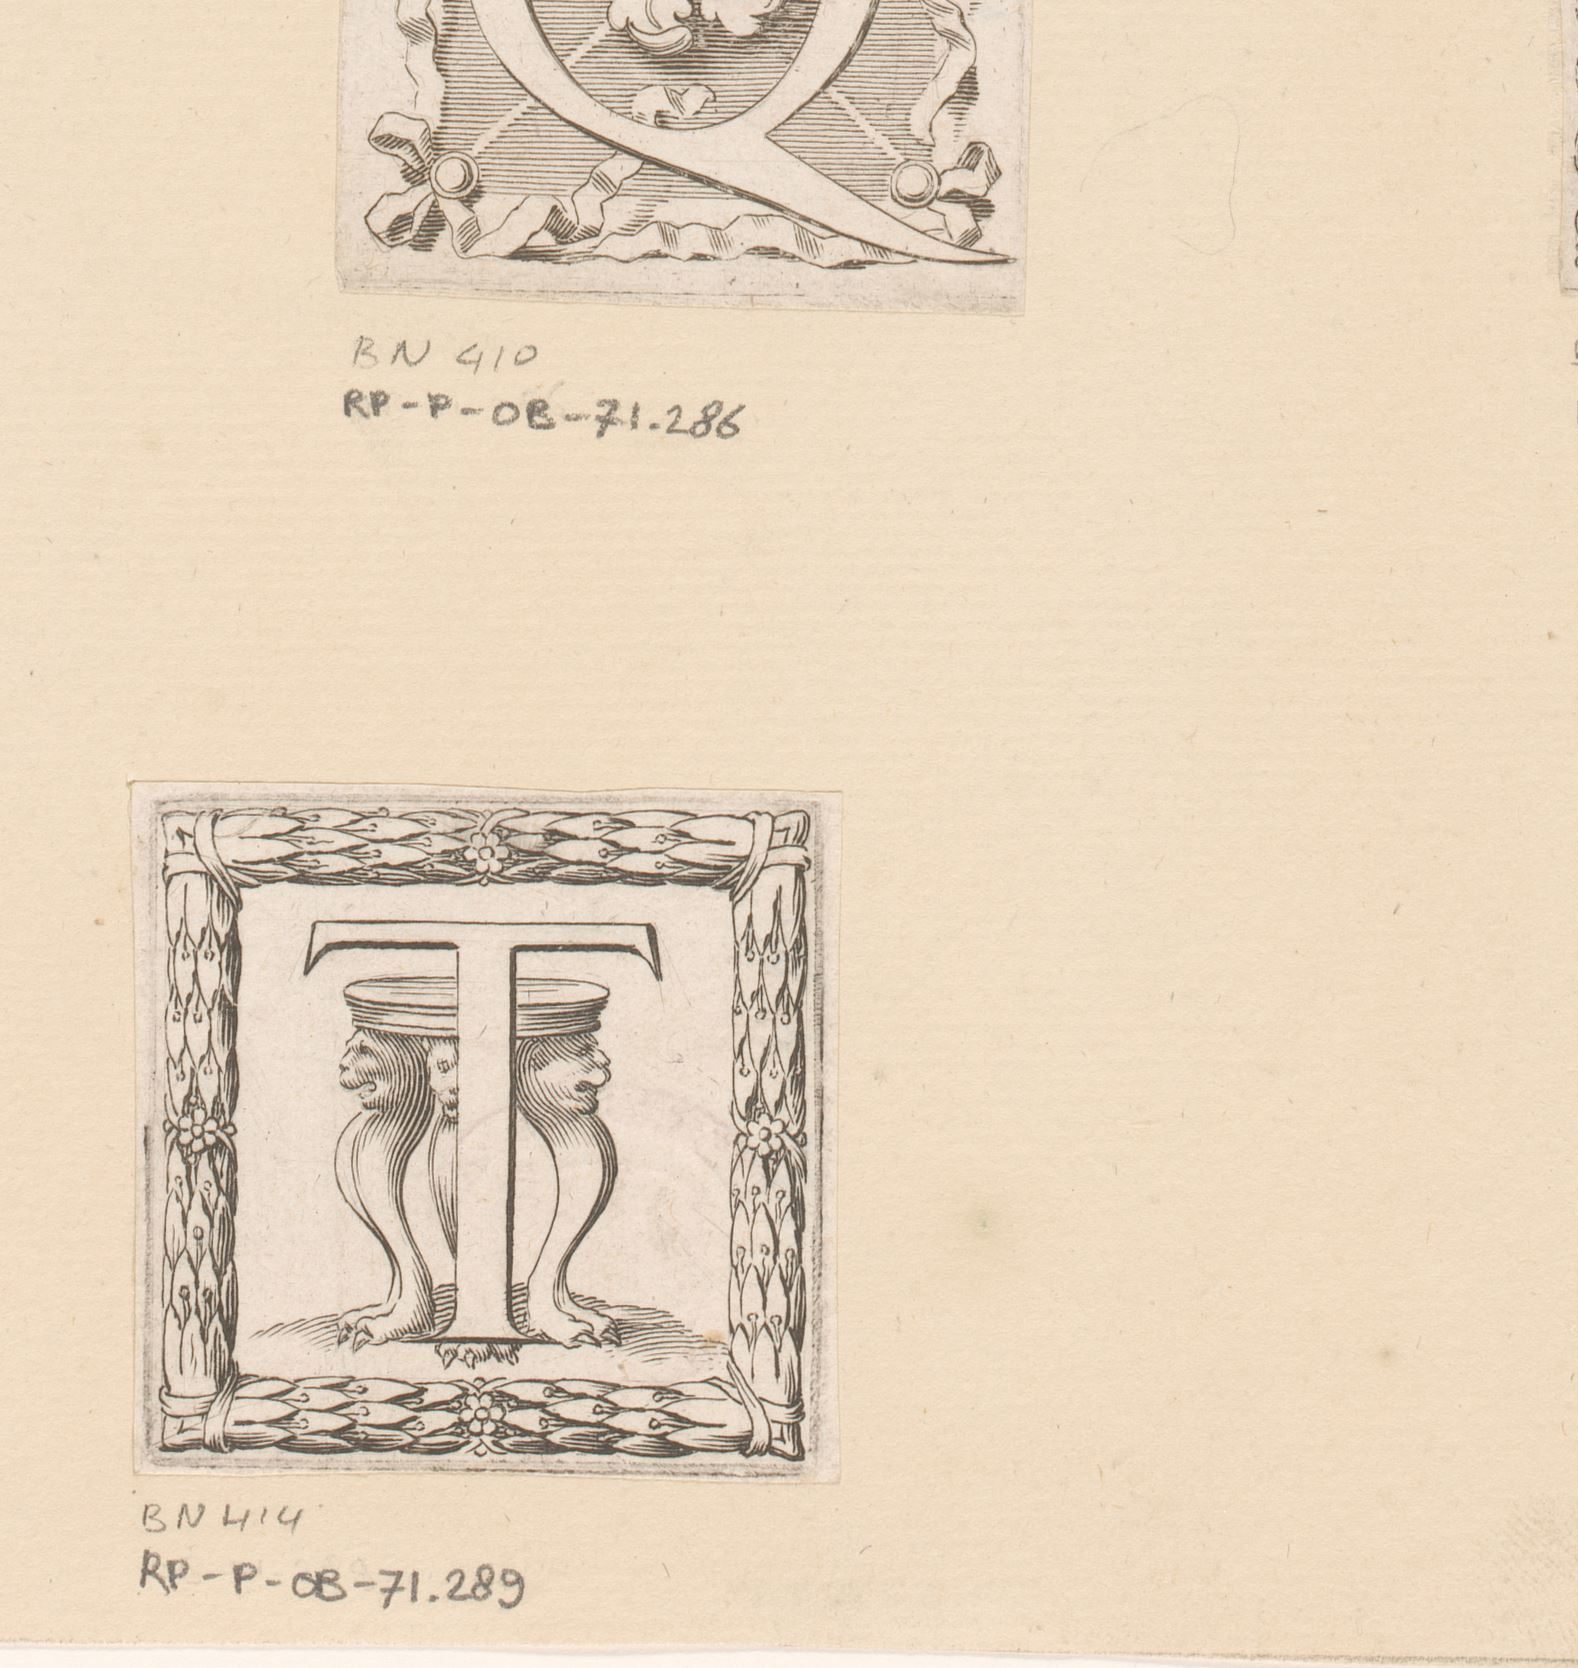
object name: print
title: Letter T met een tafel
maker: claude mellan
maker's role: draughtsman, print maker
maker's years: 1598-1688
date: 1639-1643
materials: paper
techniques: engraving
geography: france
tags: decoration of printed matter, letters, alphabet, script, table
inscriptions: collector's mark: Lugt 240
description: Dit betreft één van de 21 letters die Mellan voor de Imprimerie Royale vervaardigde. Elke letter wordt vergezeld door een afbeelding van een onderwerp dat met dezelfde letter begint. Tussen 1639-1643 werkte Mellan samen met de Imprimerie Royale (IFF 17e siècle, p. 21-22). Hij vervaardigde verschillende vignetten, letters, culs-de-lampe en decoratieve banden (IFF 17e siècle, p. 215-220). O.a. gebruikt voor de publicatie: Vergilius Maro, Publius. Publii Virgilii Maronis Opera. Parijs: Imprimerie Royale, 1641.